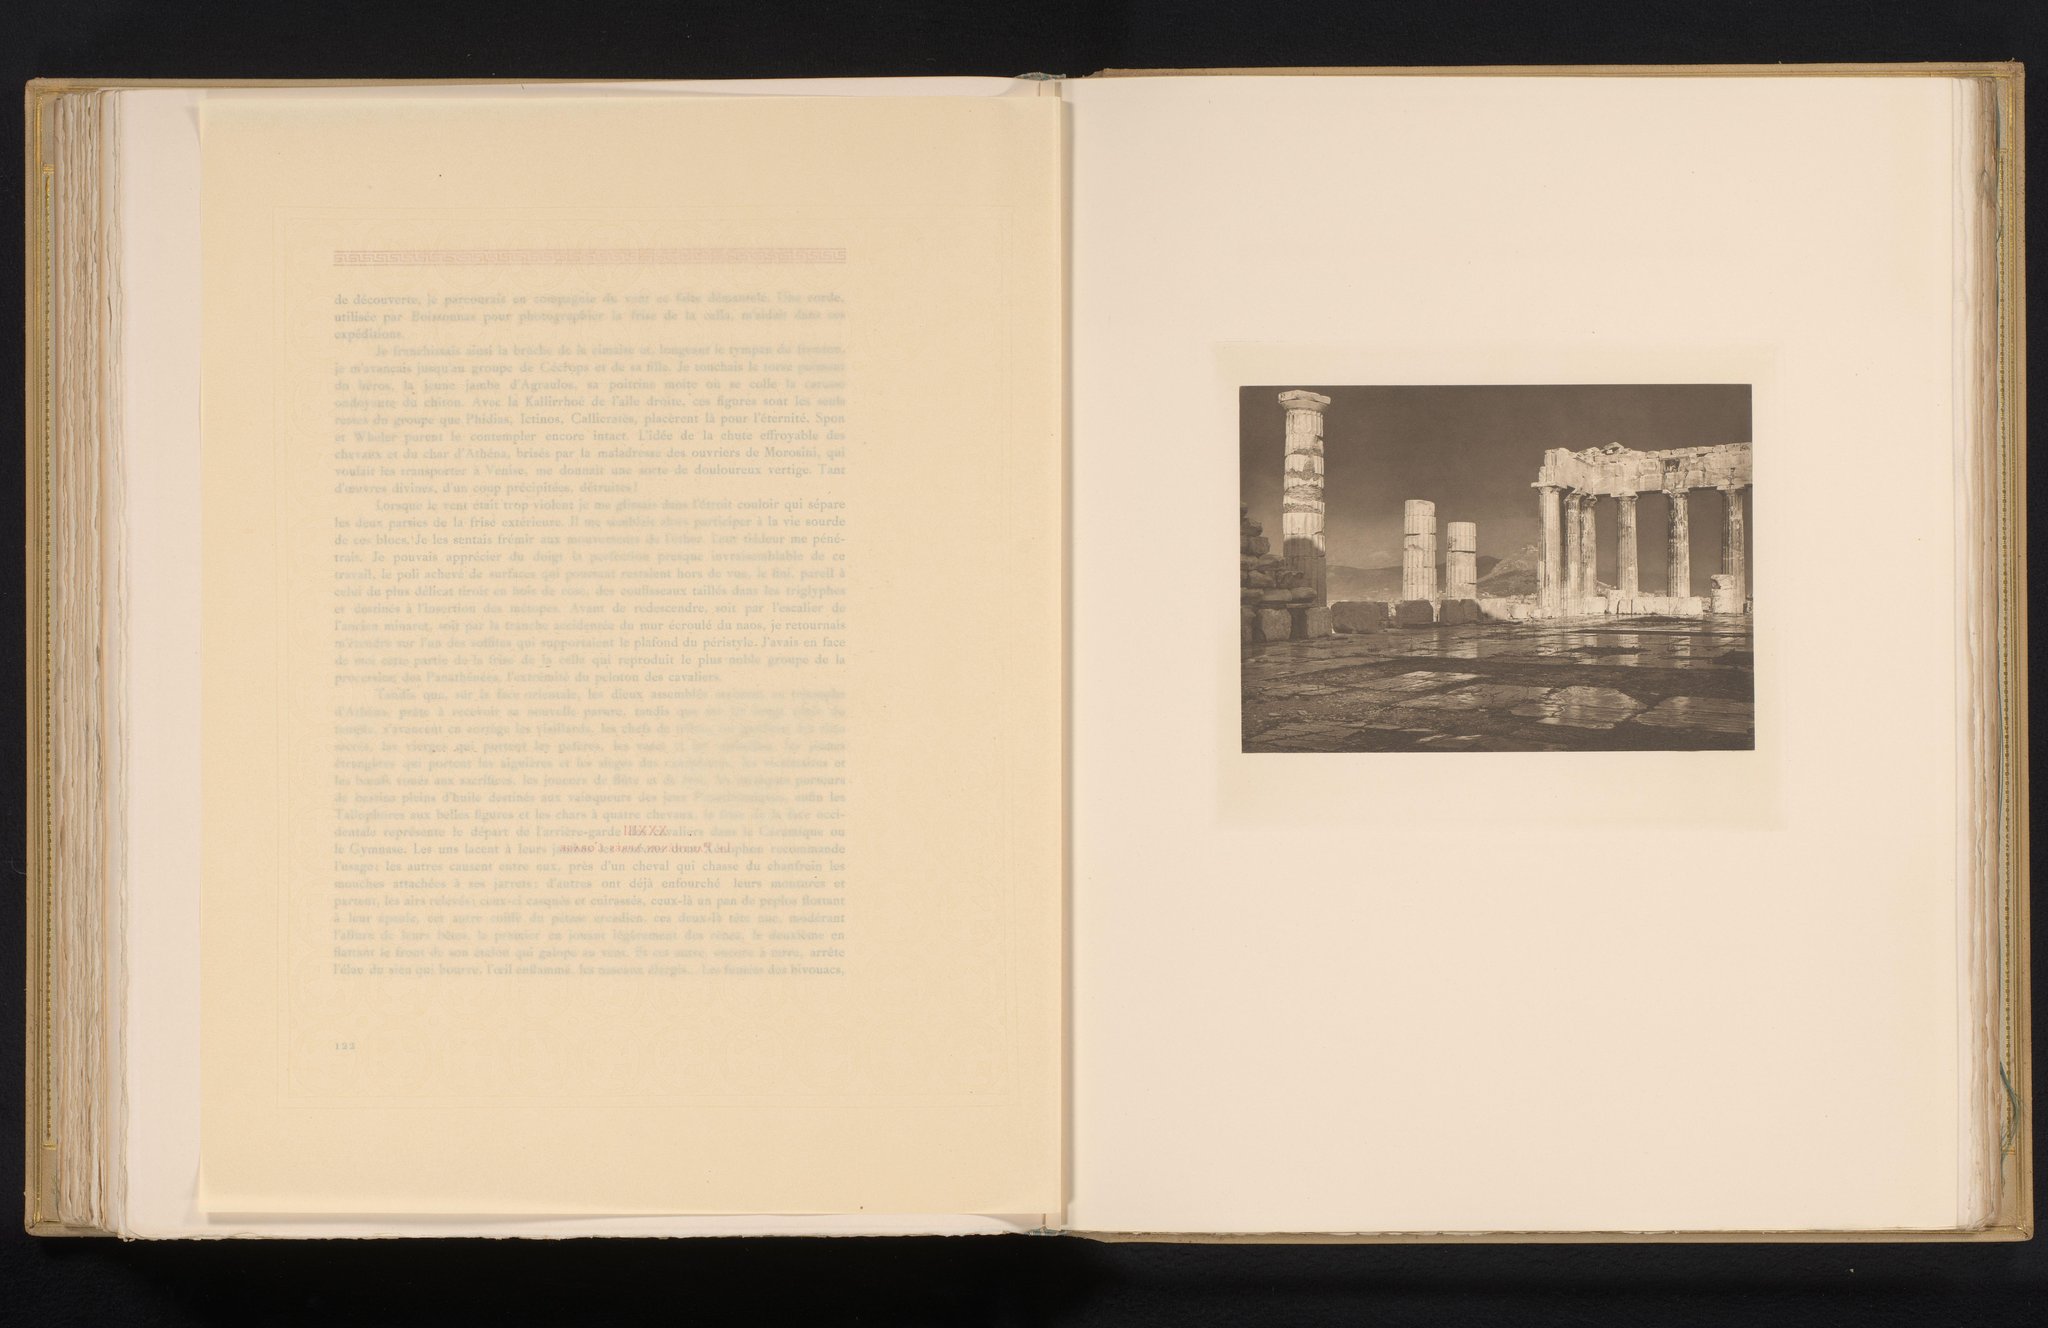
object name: page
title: Le Parthénon après l'orage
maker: frédéric boissonnas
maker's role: fotograaf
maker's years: 1858-1946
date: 1905-1910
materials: paper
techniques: photoaquatint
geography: parthenon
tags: landscape with ruins, temple, shrine ~ greek religion